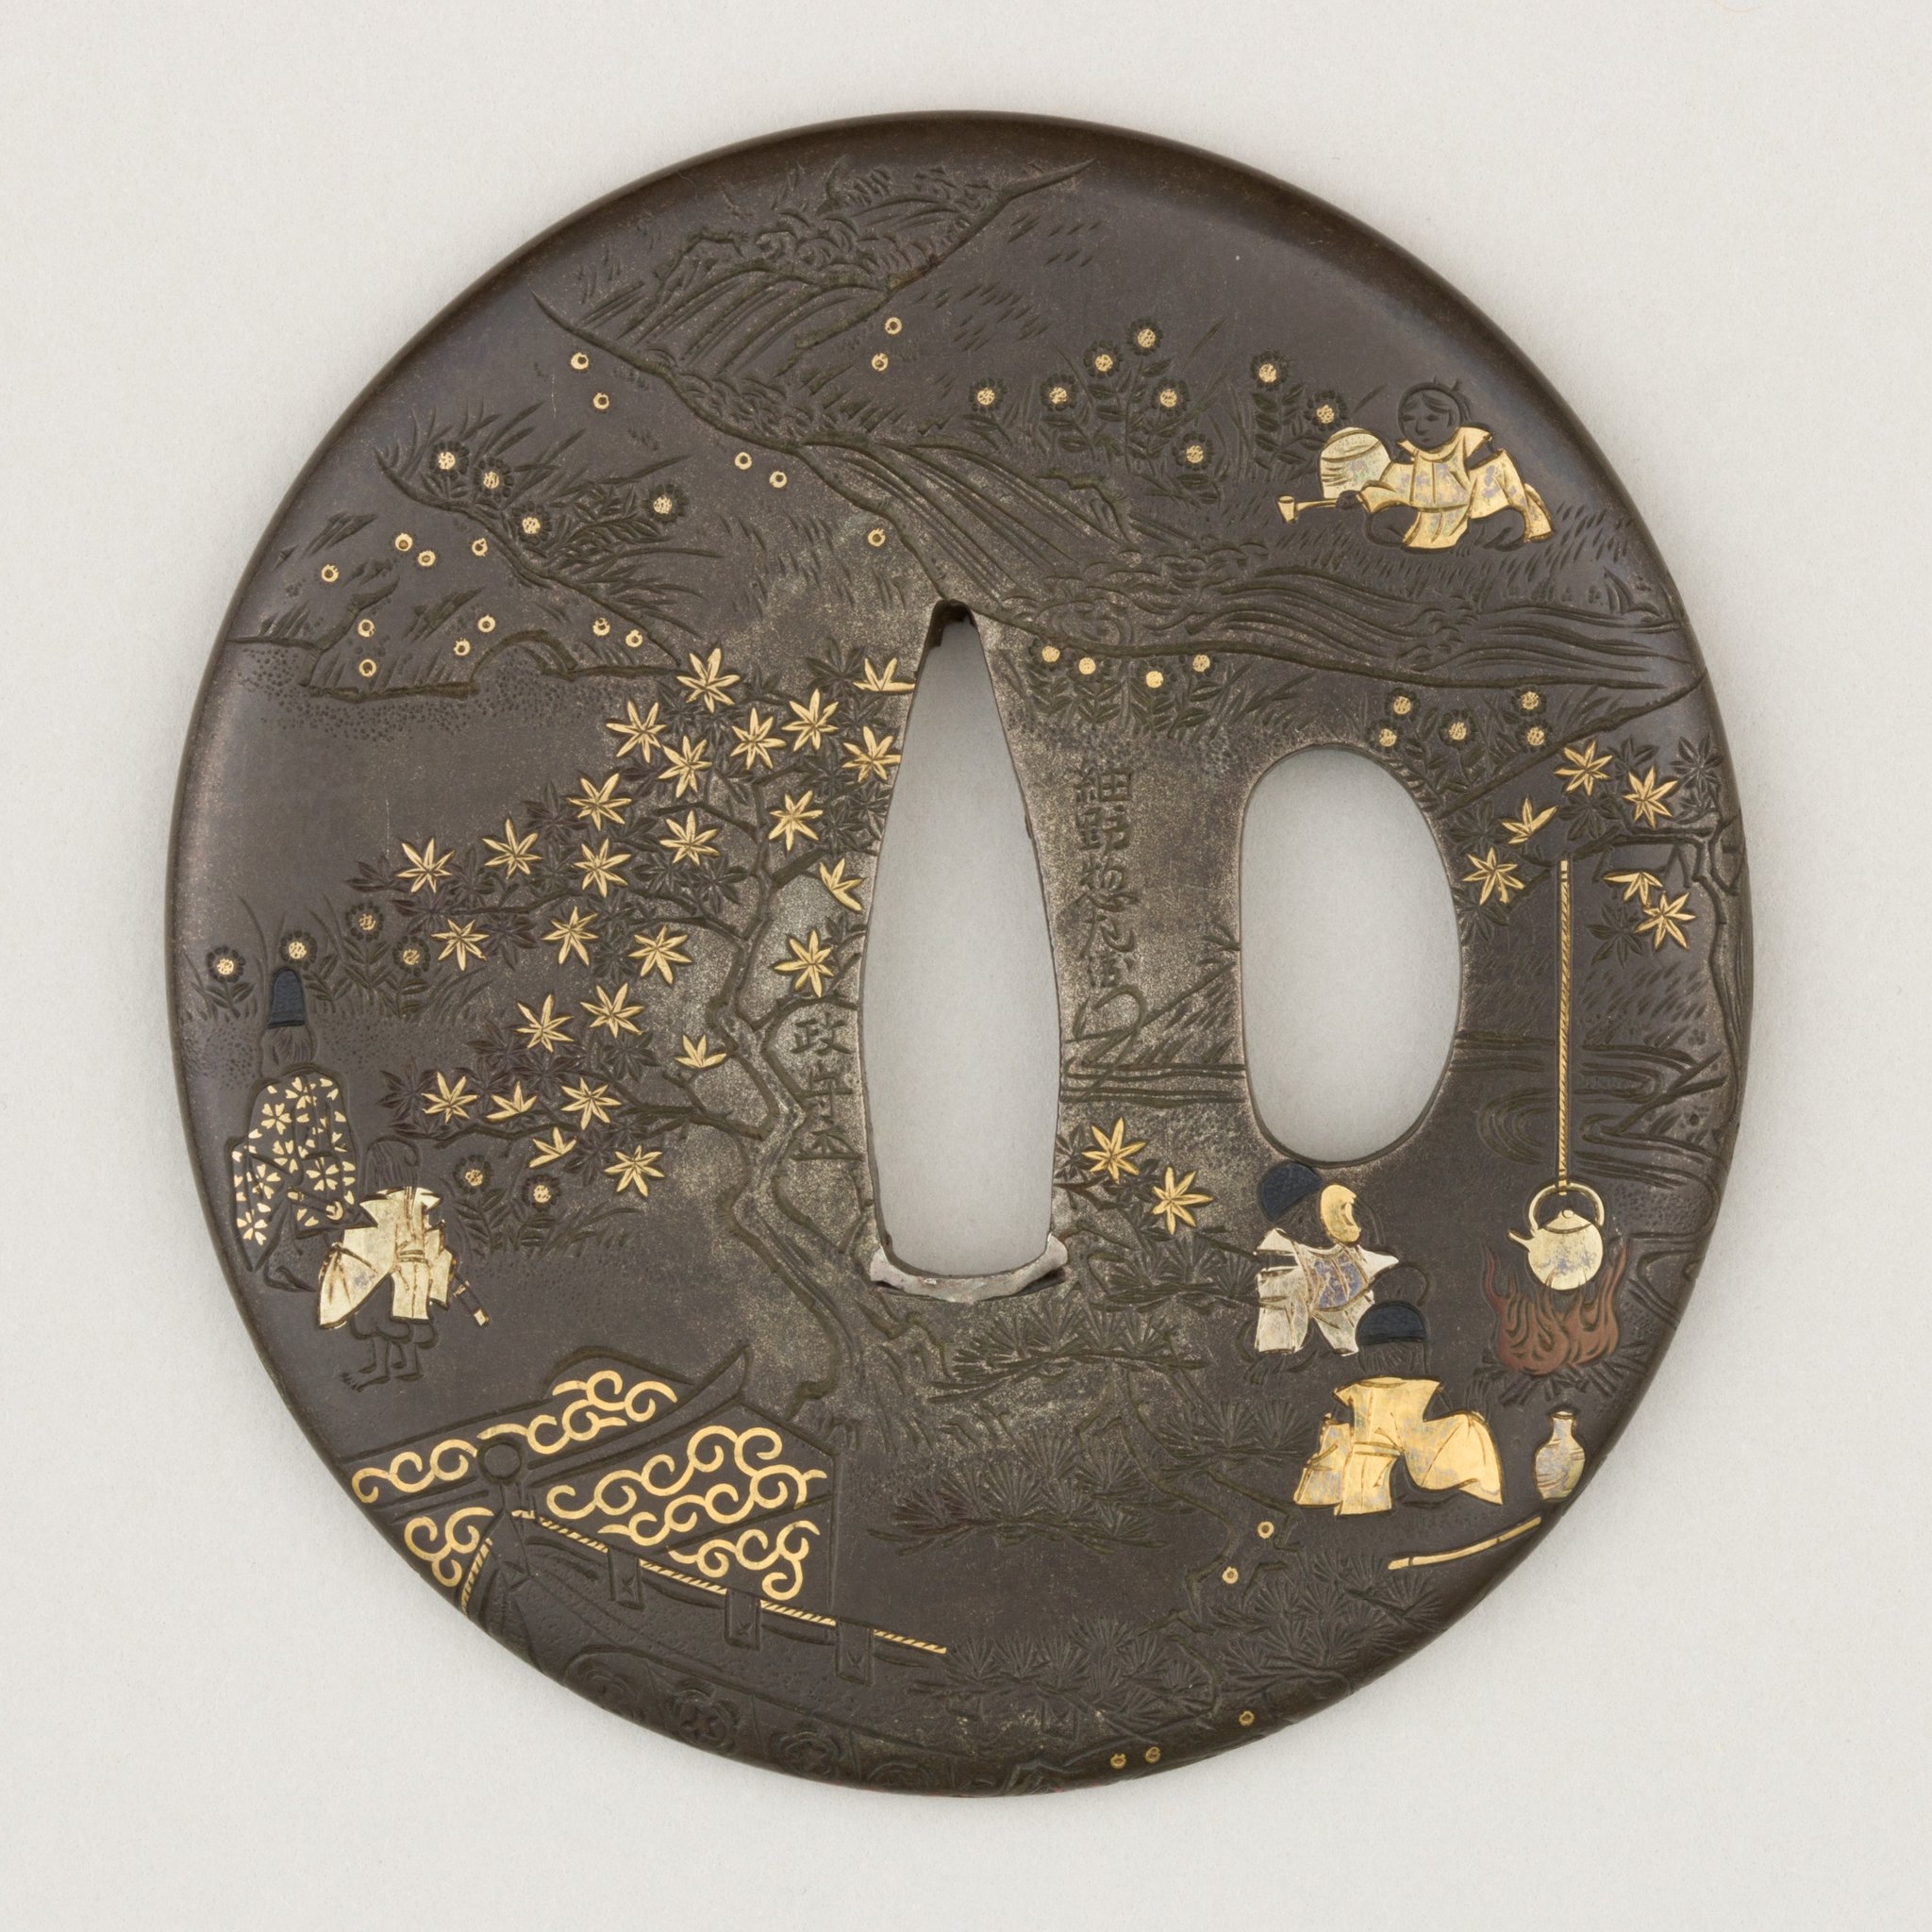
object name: sword guard tsuba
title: Sword Guard (Tsuba)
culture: japanese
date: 1801-1900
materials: bronze, copper, gold alloy, silver alloy, gold, silver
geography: japan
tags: kettles